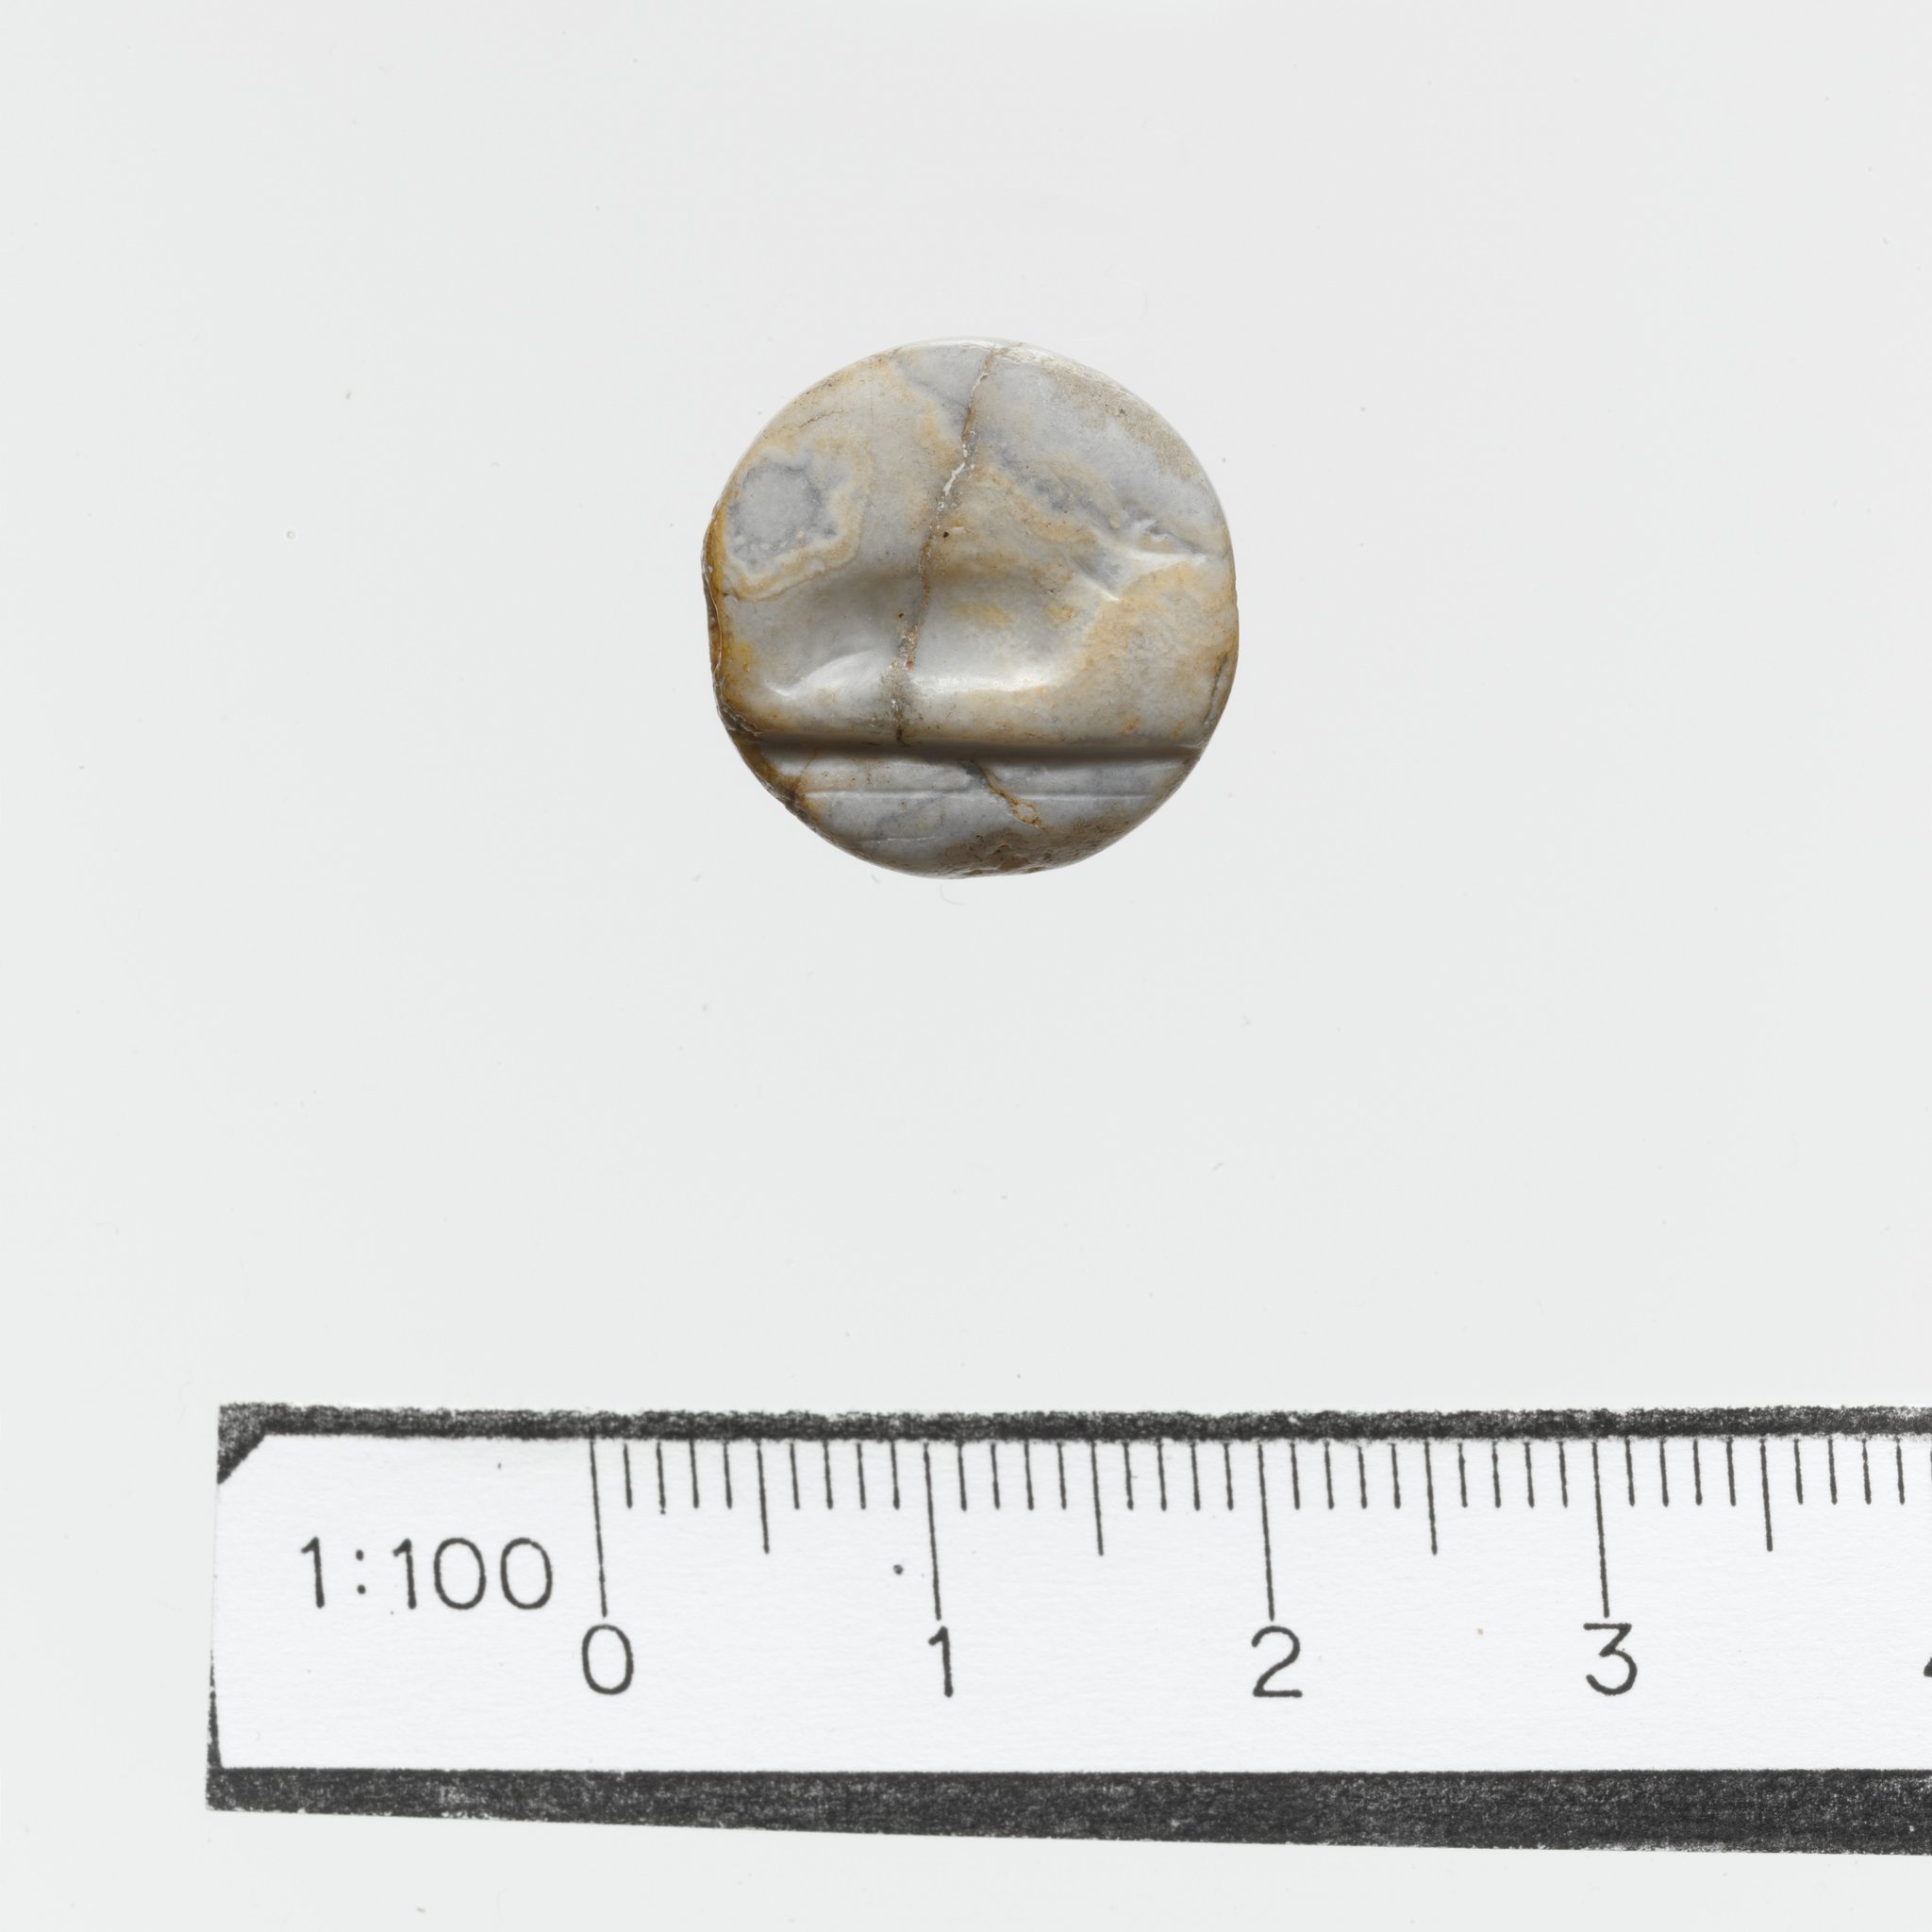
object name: seal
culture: minoan, crete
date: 2000-1450 BCE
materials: stone